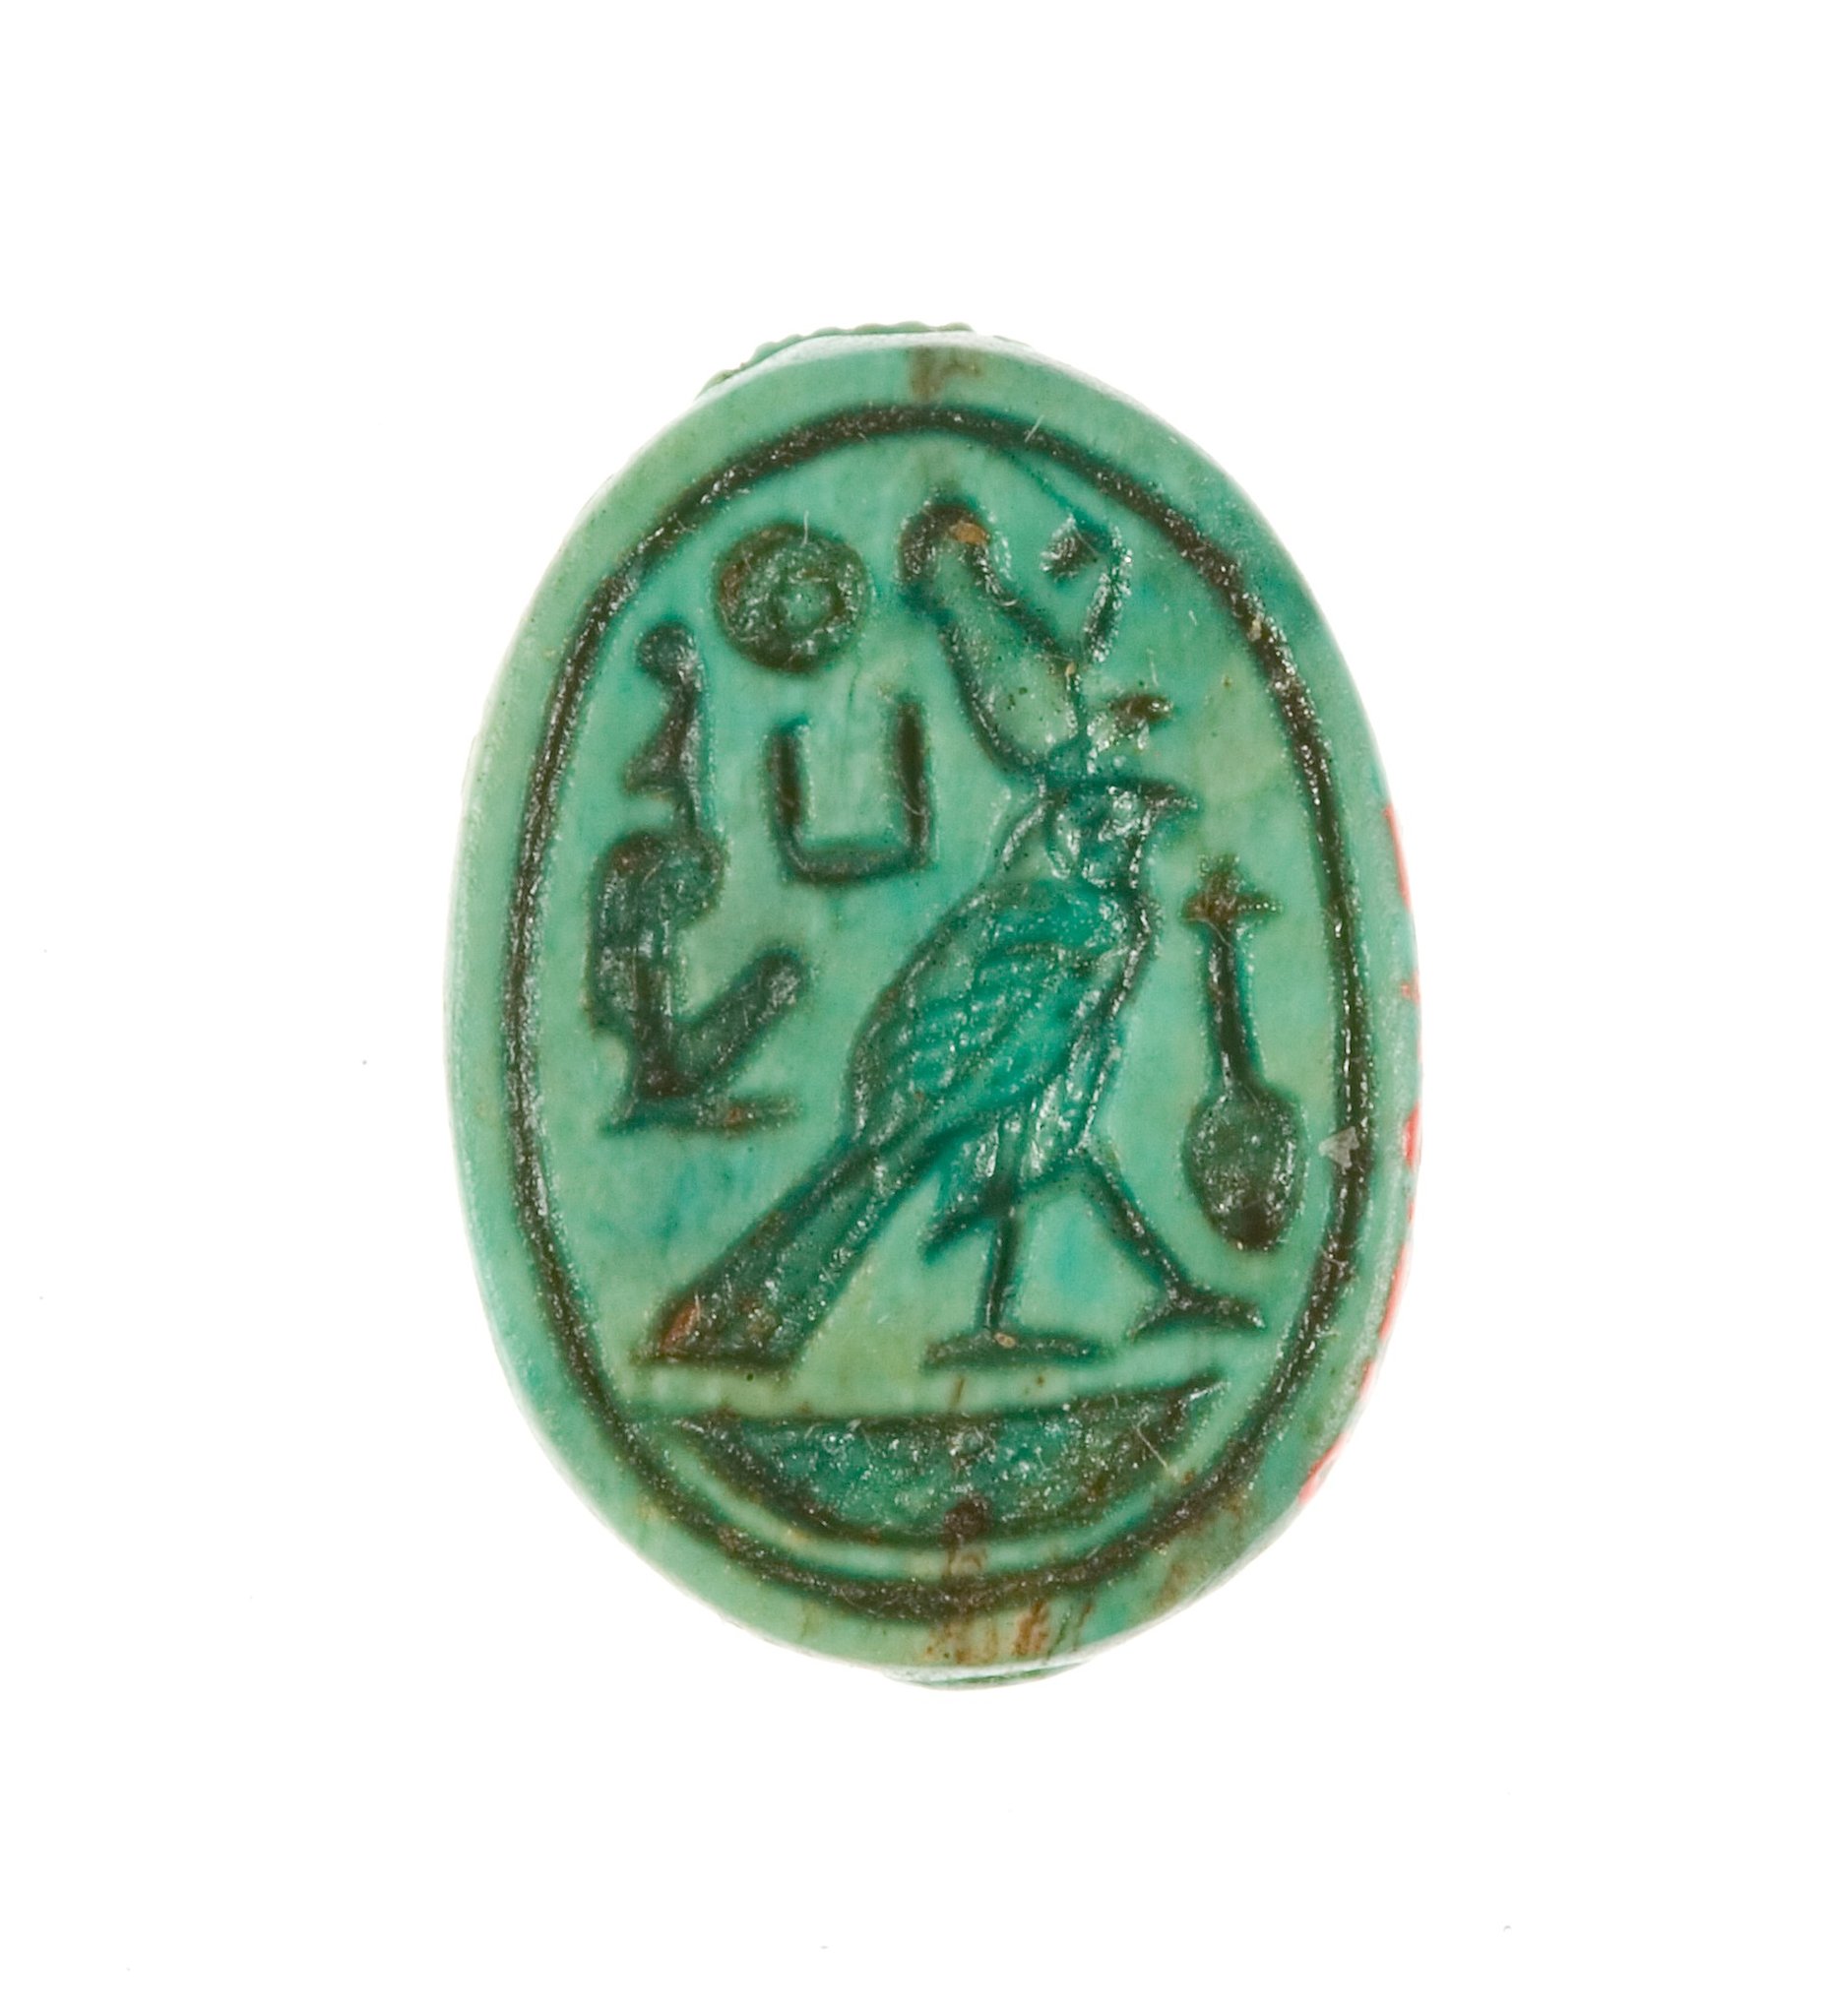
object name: scarab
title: Scarab Inscribed Perfect Horus Maatkare (Hatshepsut)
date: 1479-1458 BCE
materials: stone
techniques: glazing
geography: egypt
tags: hieroglyphs,scarabs